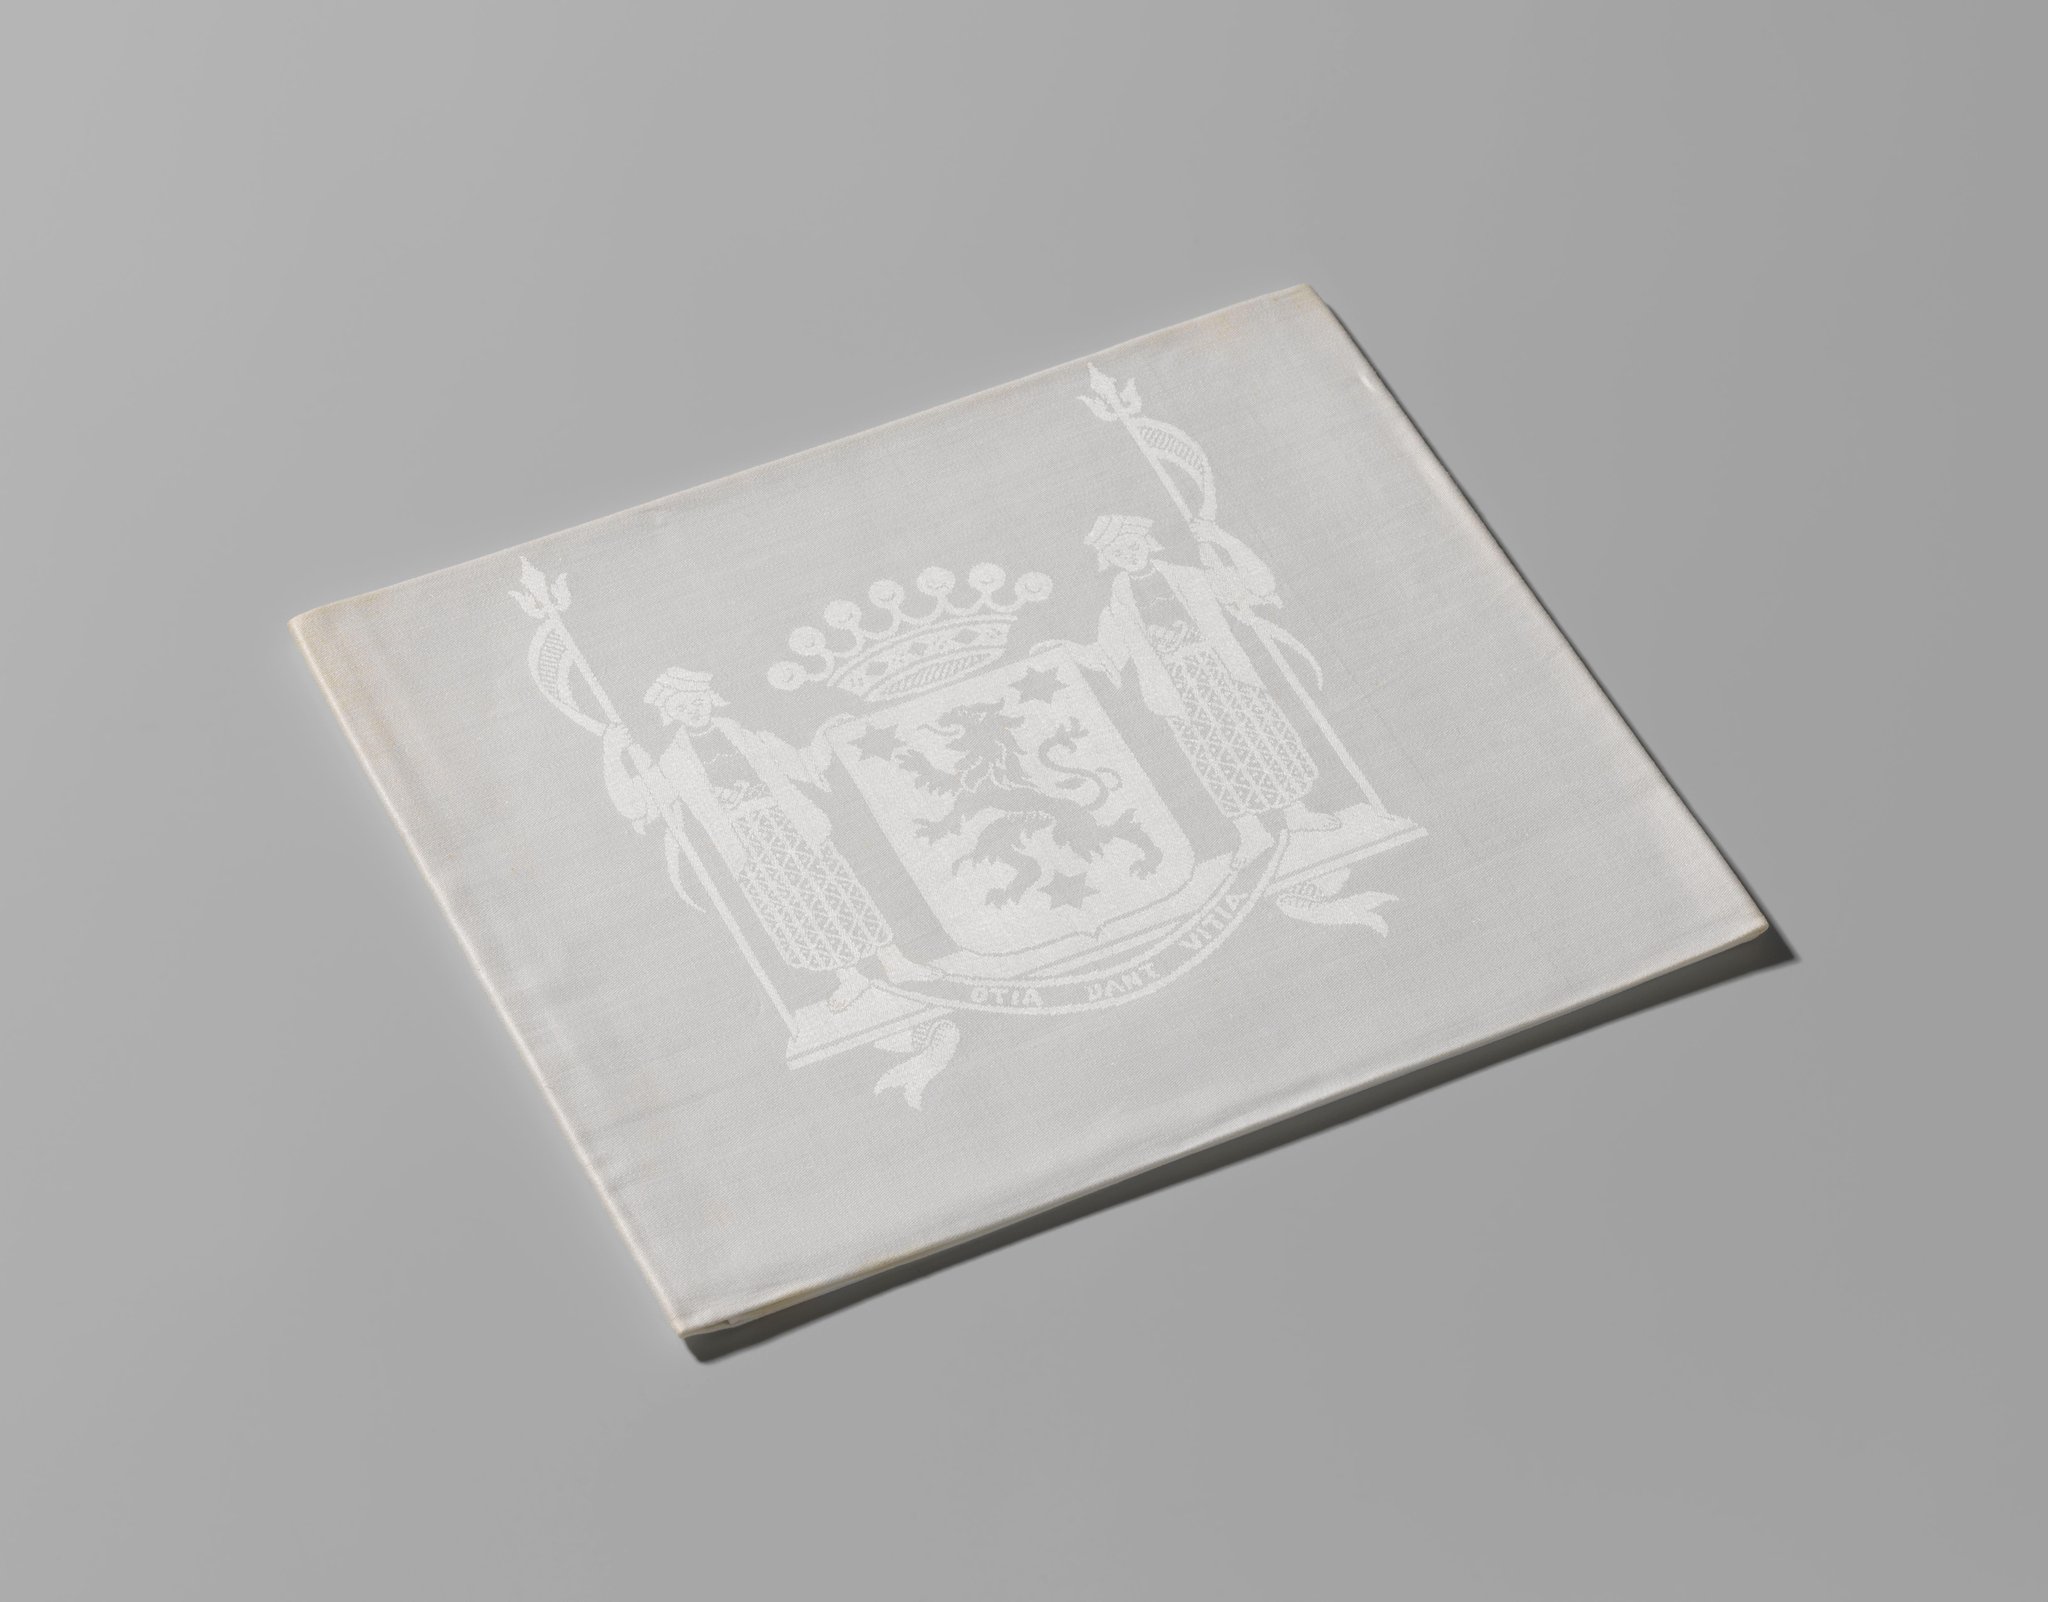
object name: napkin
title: Servet van wit linnendamast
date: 1852-1889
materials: linen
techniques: damask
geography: veghel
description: Wit linnen damasten servet met eikentakken en het wapen van de baronnen Baud. Gemerkt BvH.